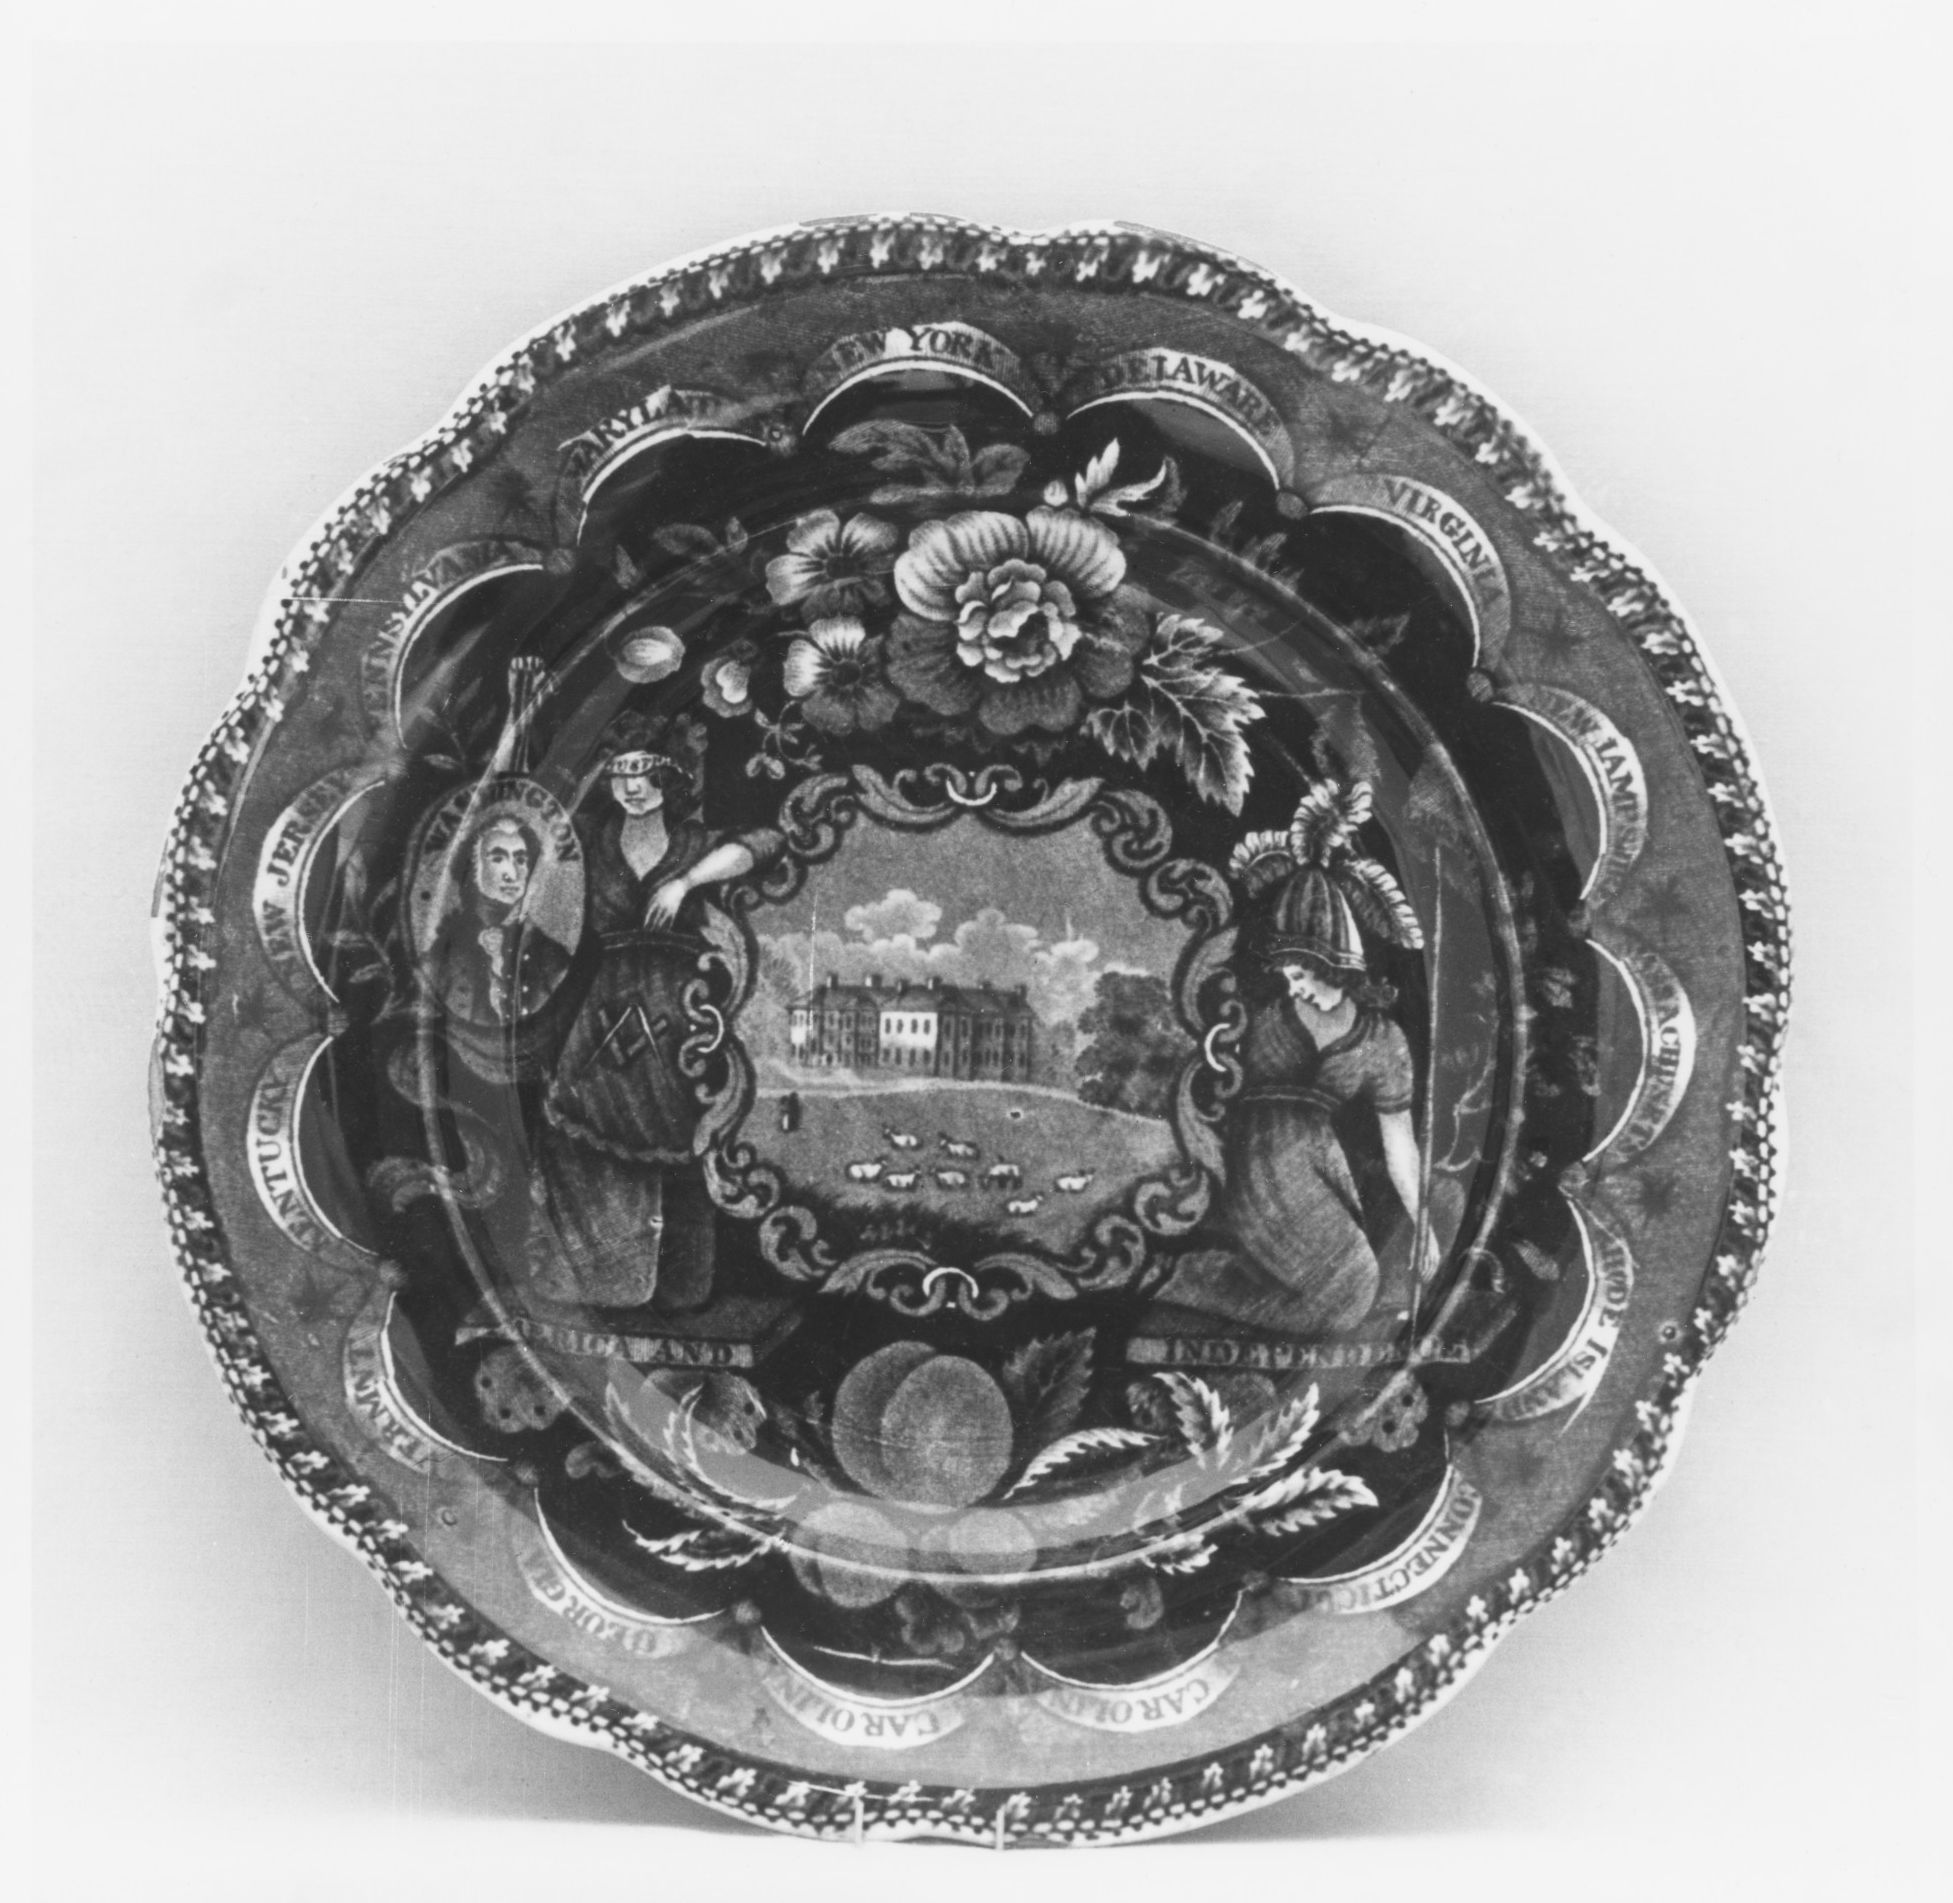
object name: platter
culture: british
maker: james and ralph clews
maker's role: maker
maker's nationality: british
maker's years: 1813-1836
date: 1815-1834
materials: earthenware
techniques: transfer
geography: england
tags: buildings,george washington,flowers